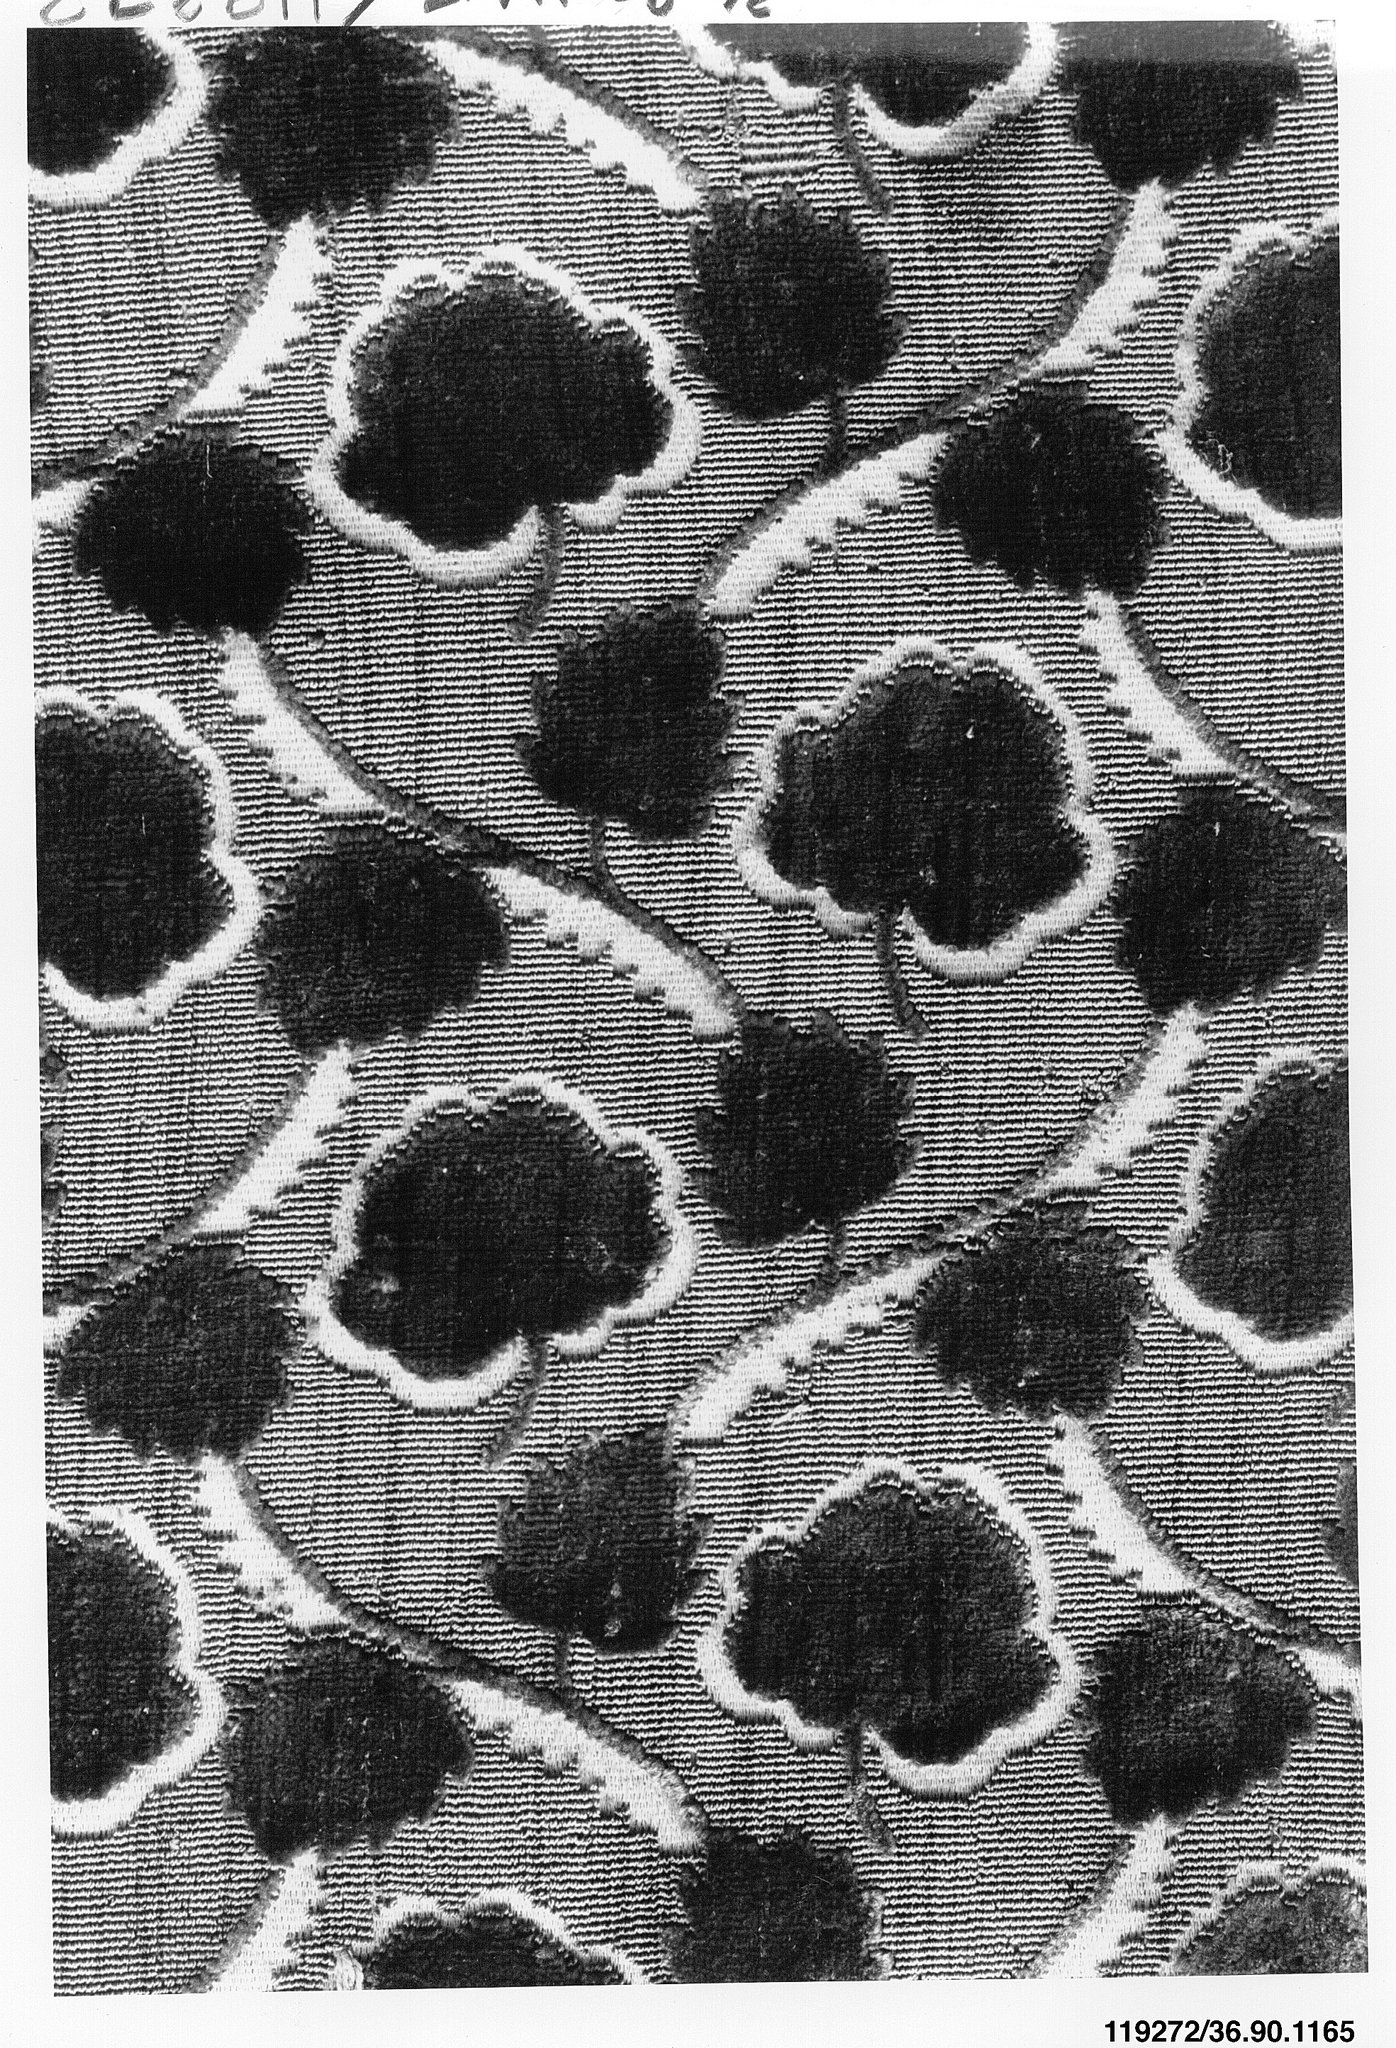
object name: piece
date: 1701-1800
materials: silk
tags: leaves